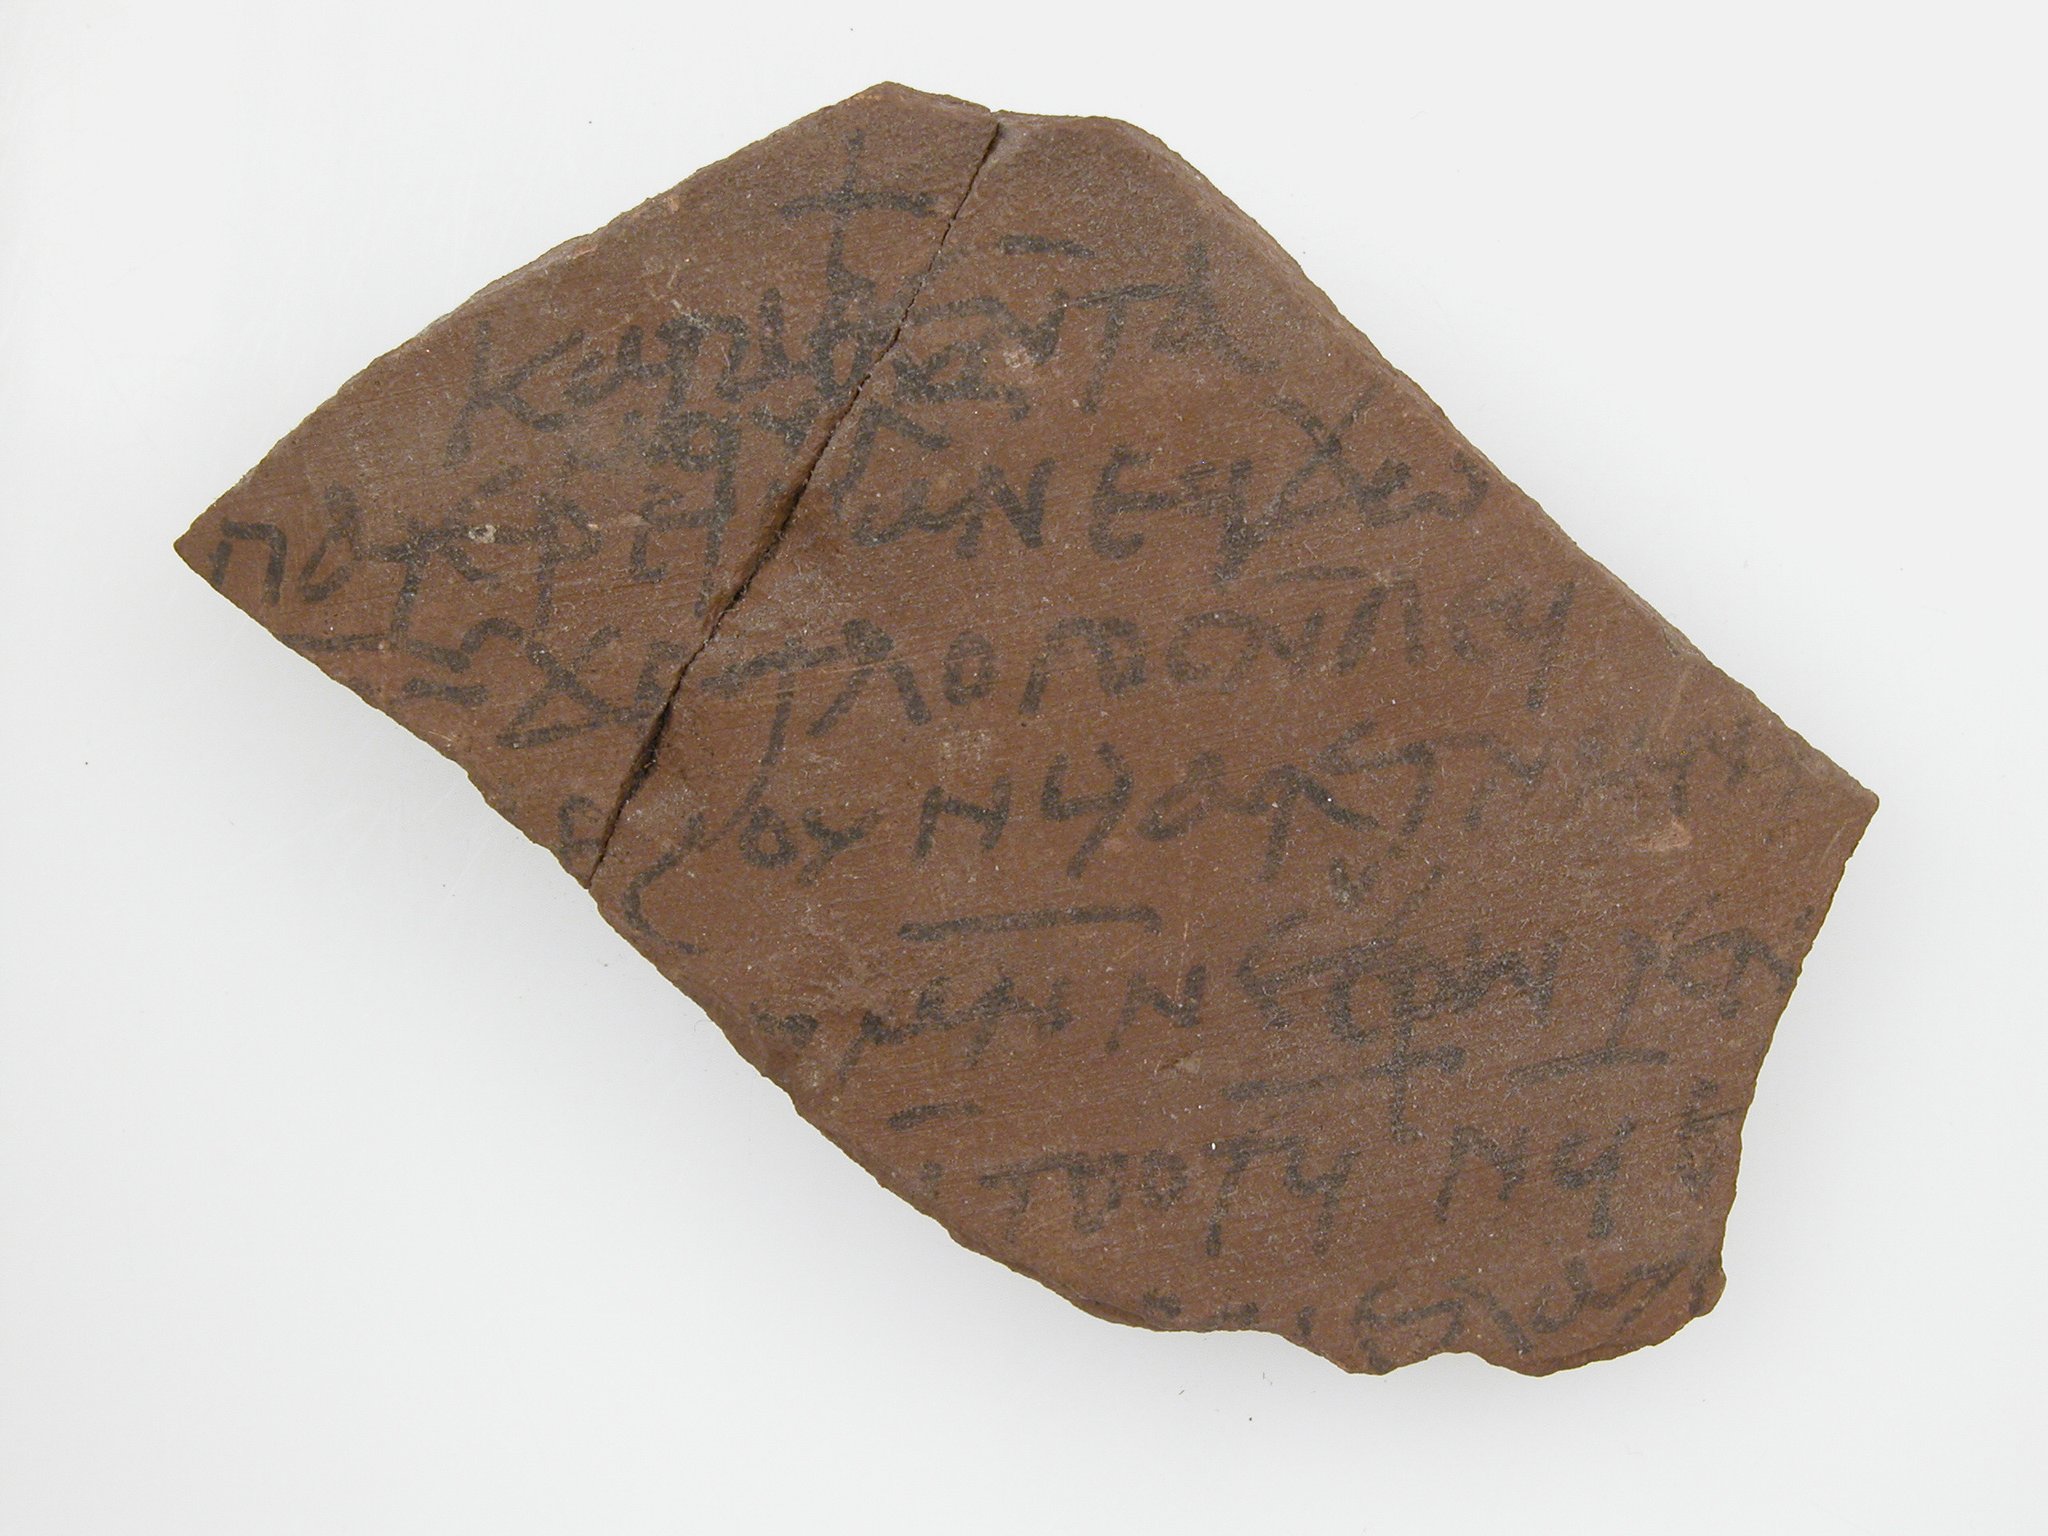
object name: ostrakon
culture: coptic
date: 601-700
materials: ink, pottery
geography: egypt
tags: coptic